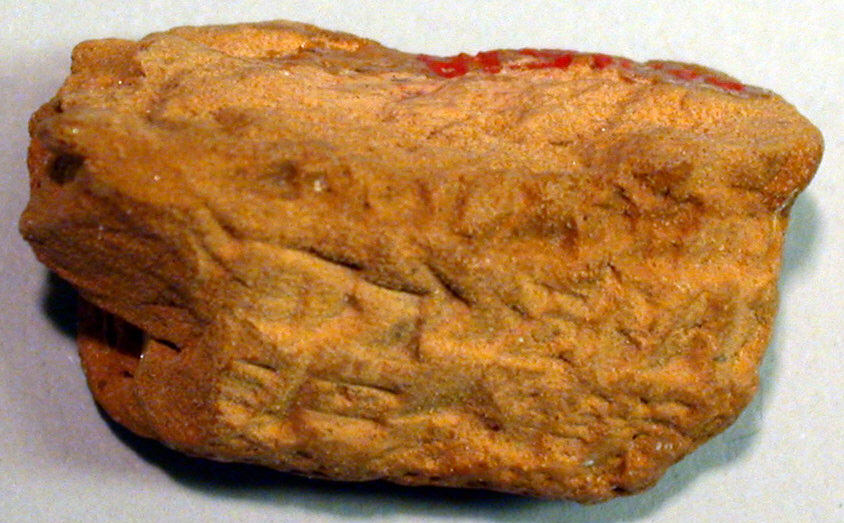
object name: cuneiform tablet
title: Cuneiform tablet: fragment, Ebabbar archive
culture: achaemenid or babylonian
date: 700-301 BCE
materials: clay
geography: mesopotamia